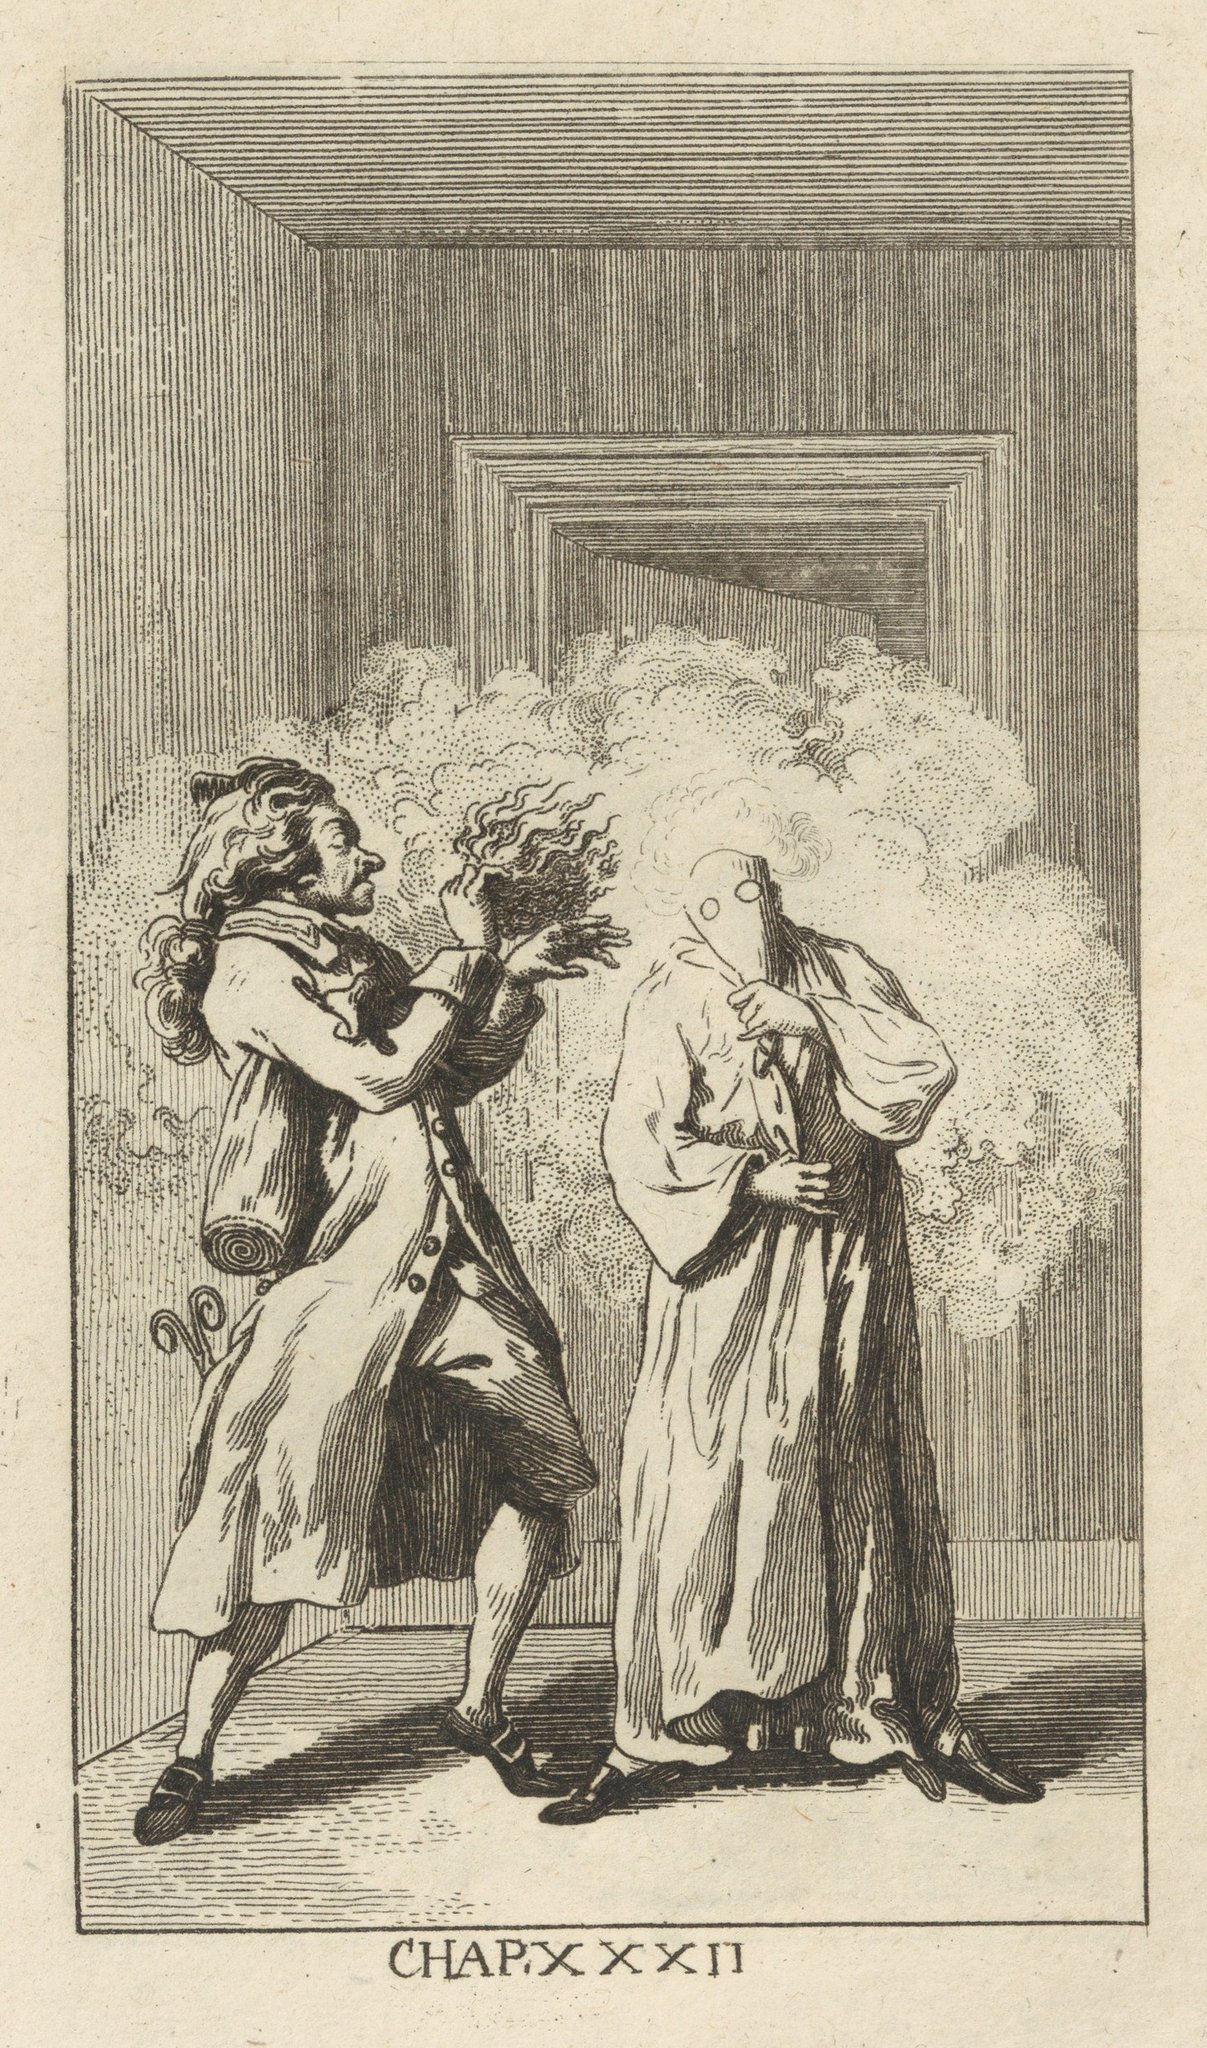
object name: book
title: Tableau de Paris, ou Explication de Differentes Figures, gravées a l'eau-forte, pour servir aux différentes Editions du Tableau de Paris...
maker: louis sébastien mercier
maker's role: author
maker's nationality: french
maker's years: 1740-1814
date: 1787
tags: men